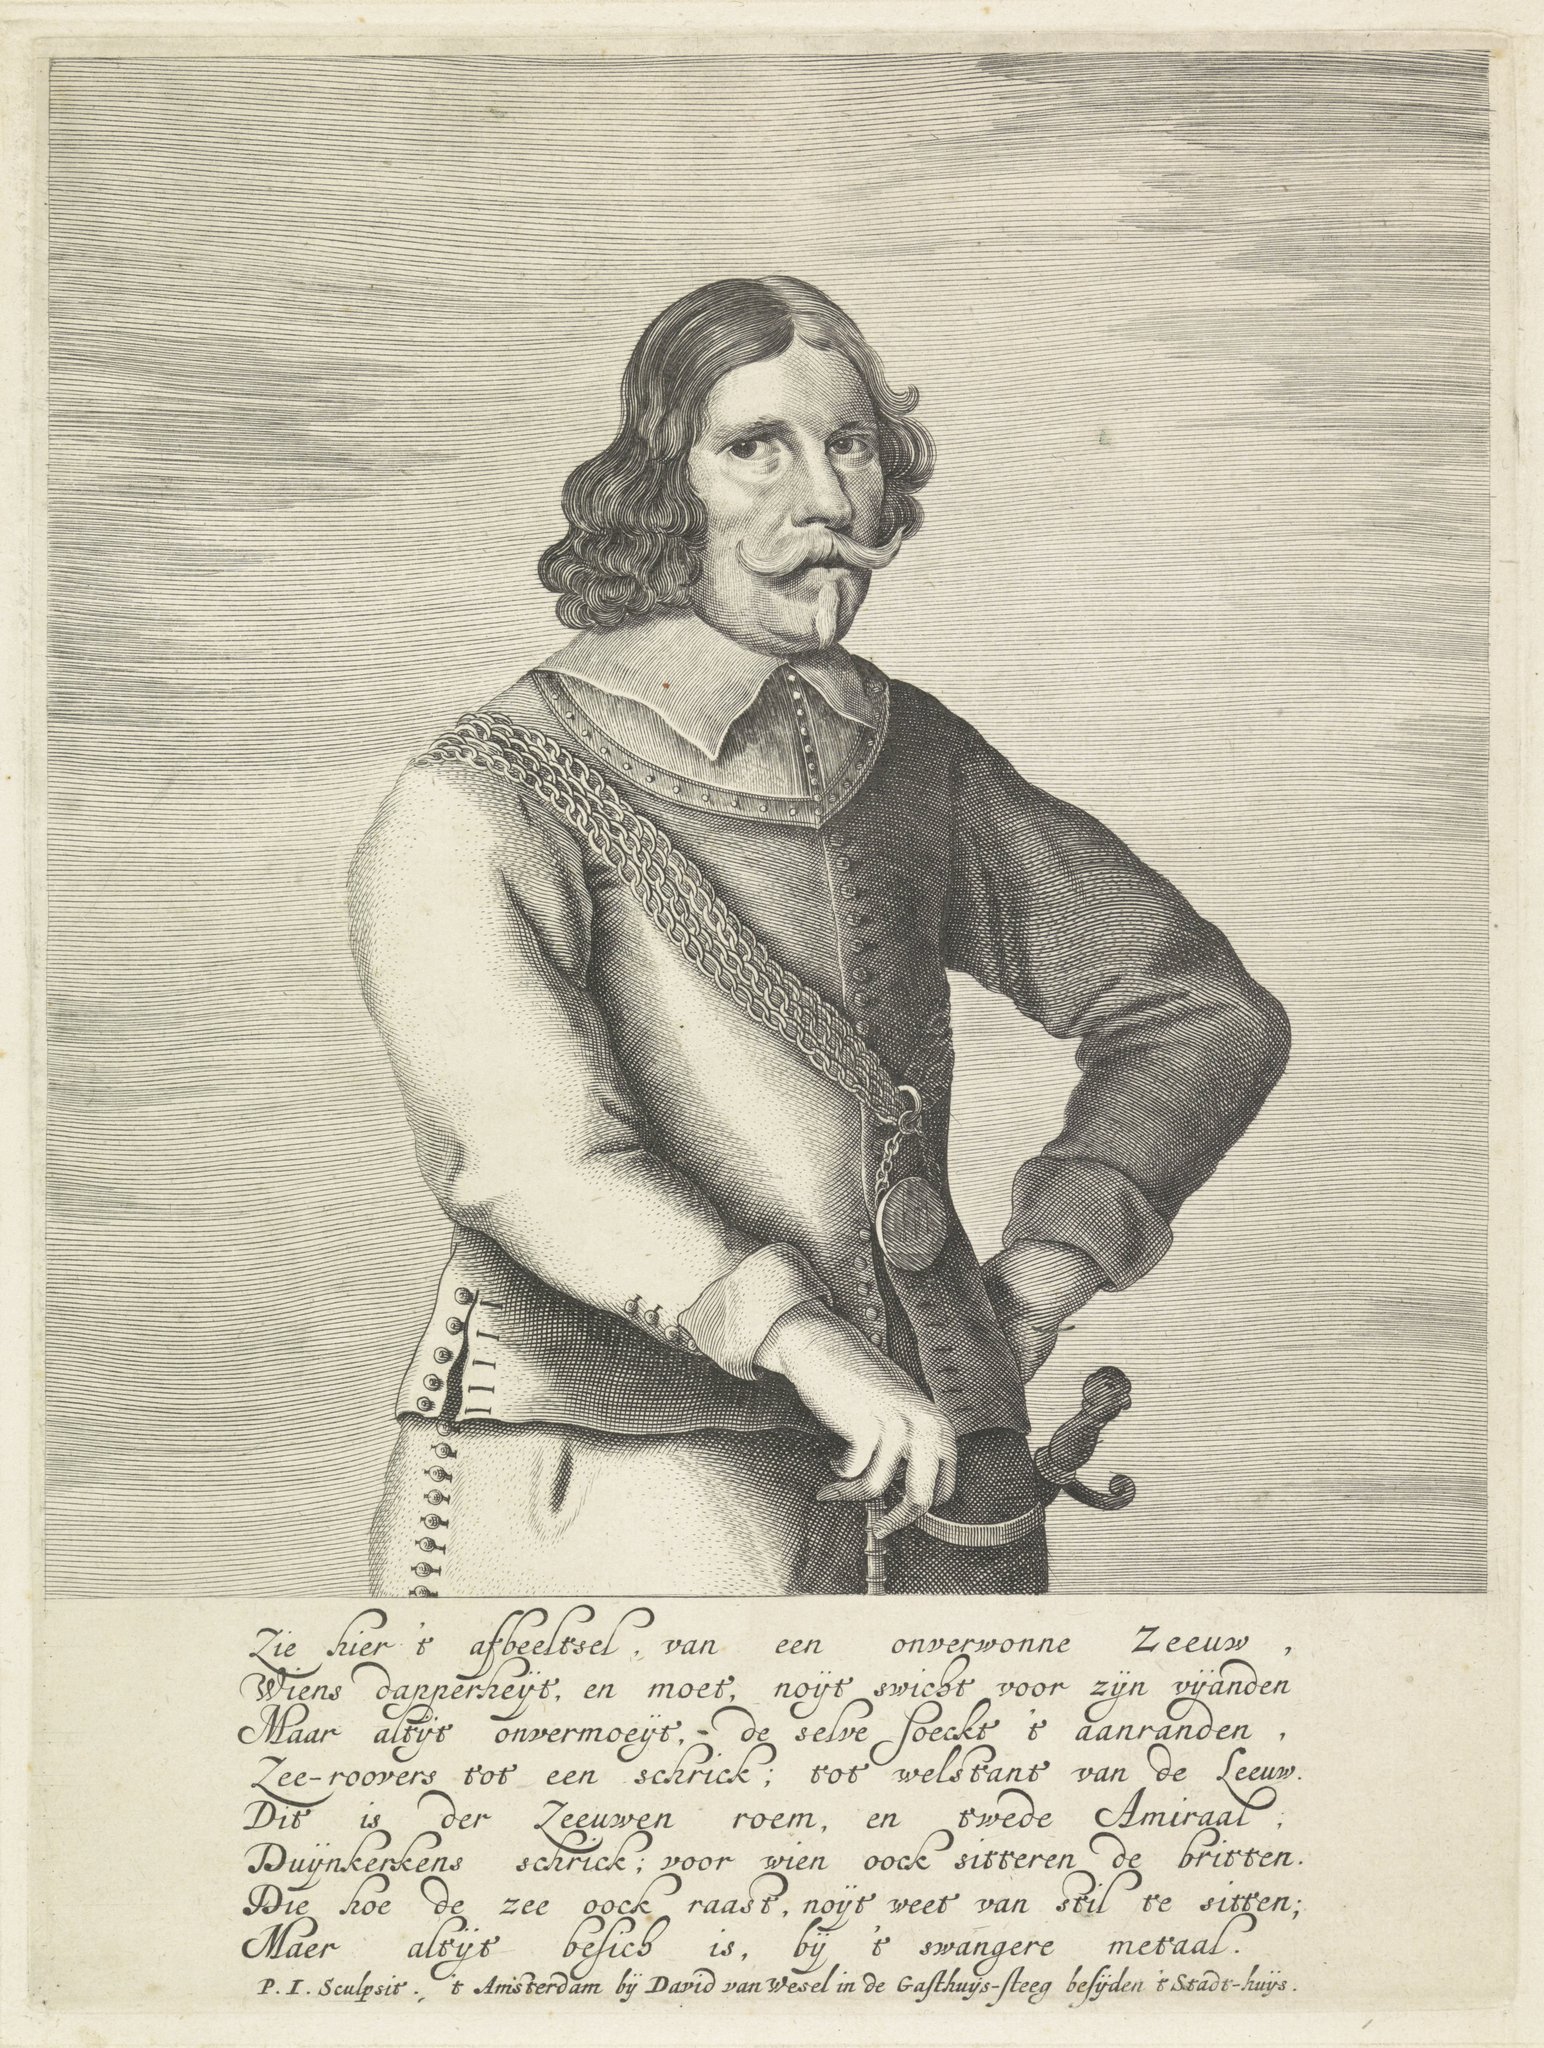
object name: print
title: Portret van Johan Evertsen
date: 1649-1657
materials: paper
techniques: engraving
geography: amsterdam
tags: flushing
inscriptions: collector's mark: Lugt 240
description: Portret van de Zeeuwse admiraal Johan Evertsen.